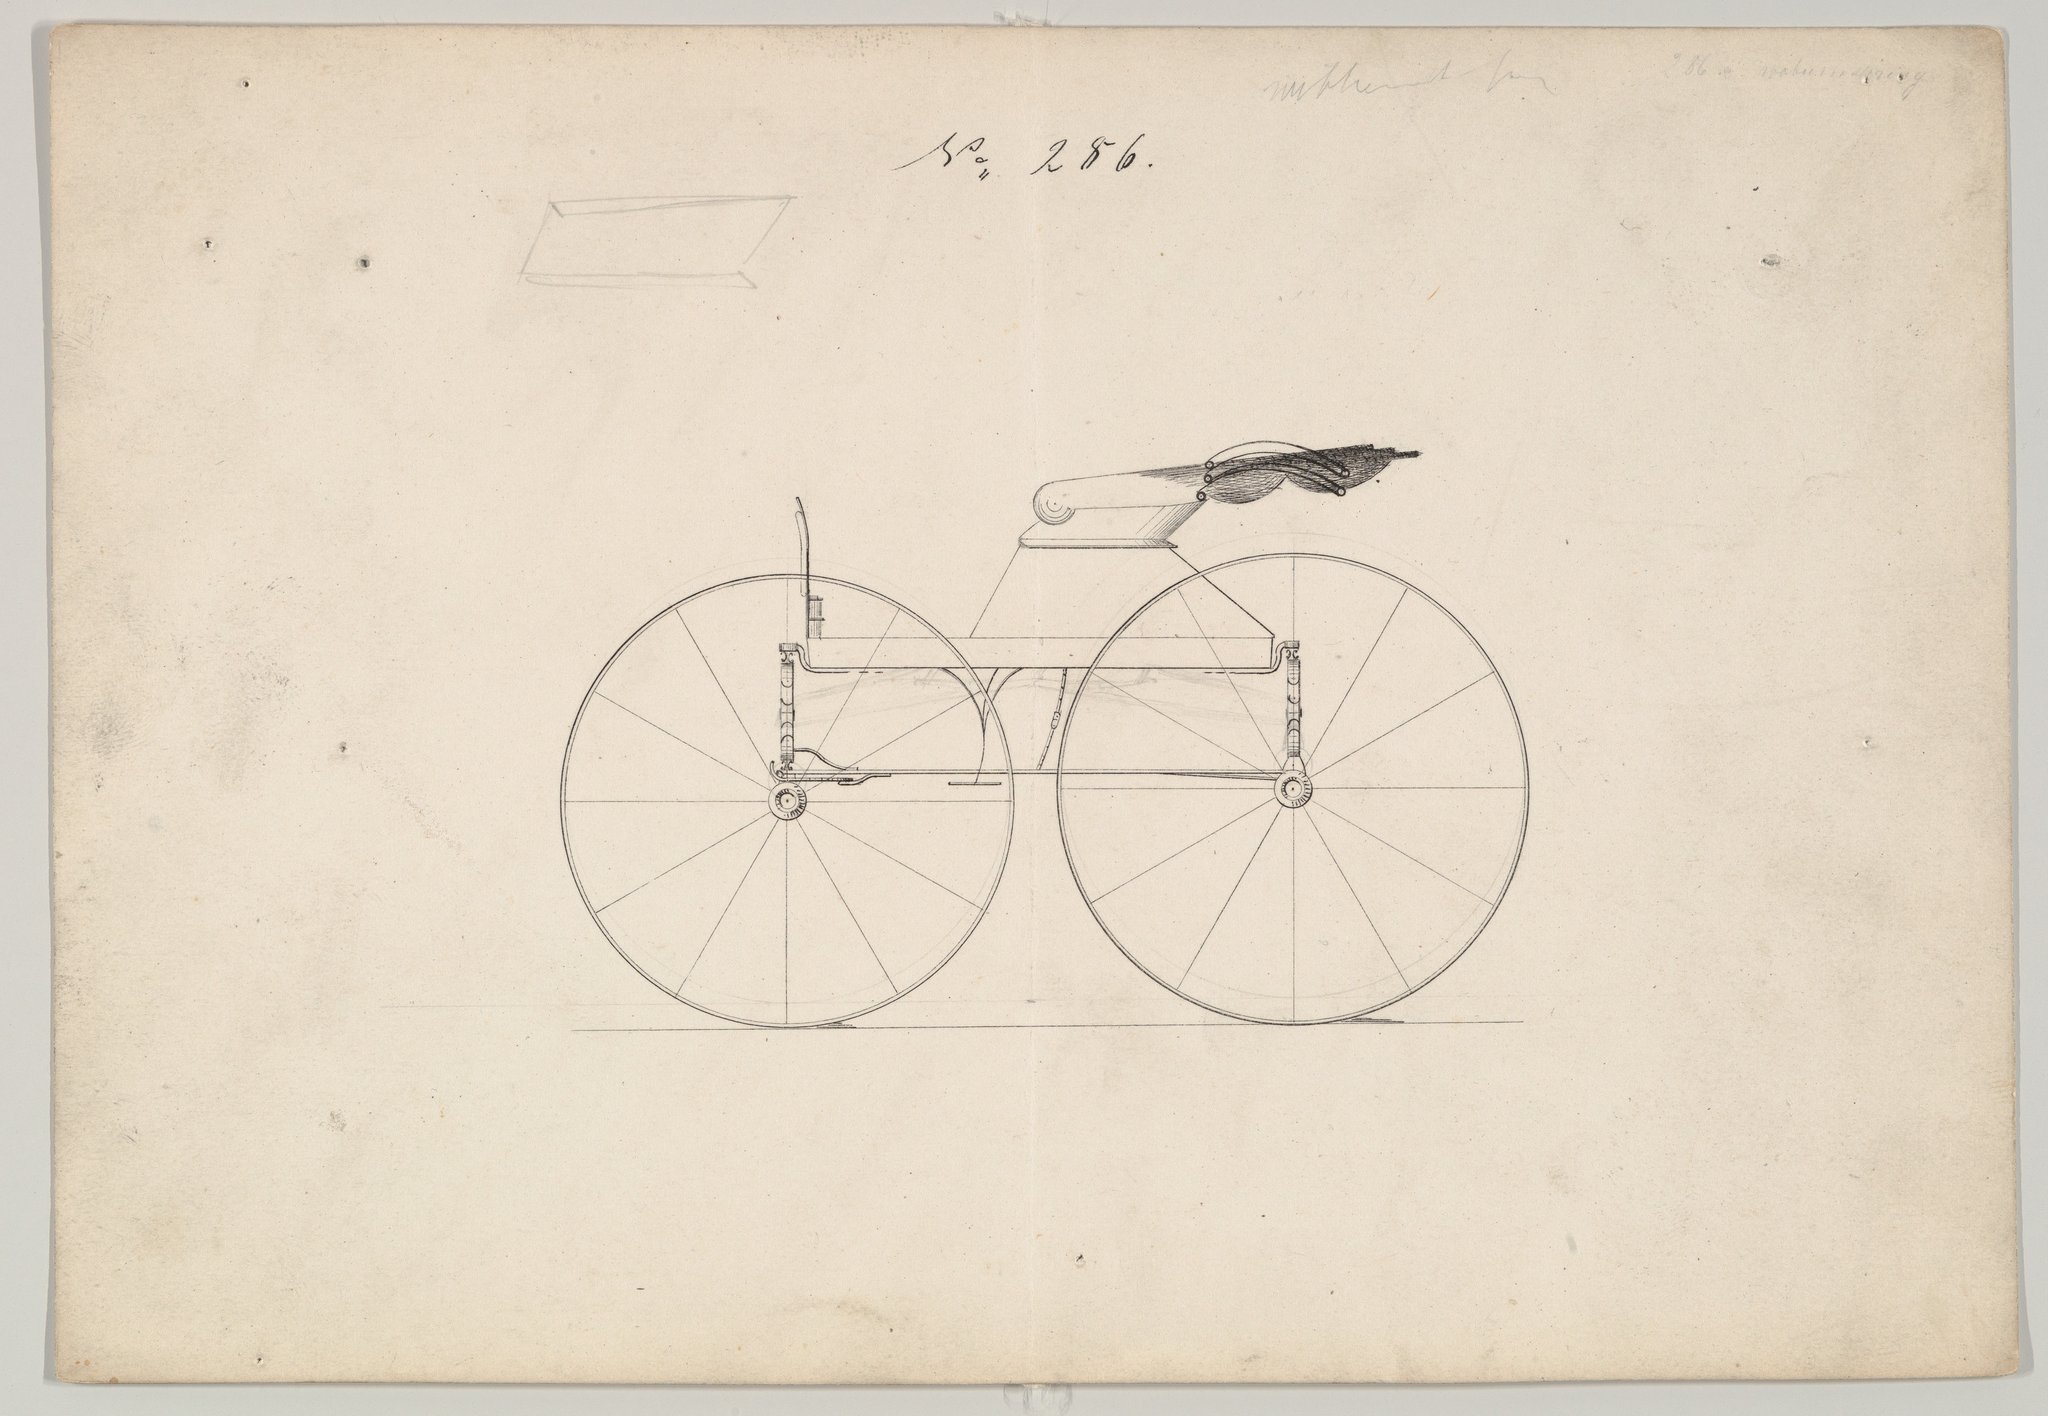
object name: drawing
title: Wagon #286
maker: brewster & co.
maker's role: manufacturer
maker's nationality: american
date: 1859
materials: graphite, ink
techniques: pen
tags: carriages